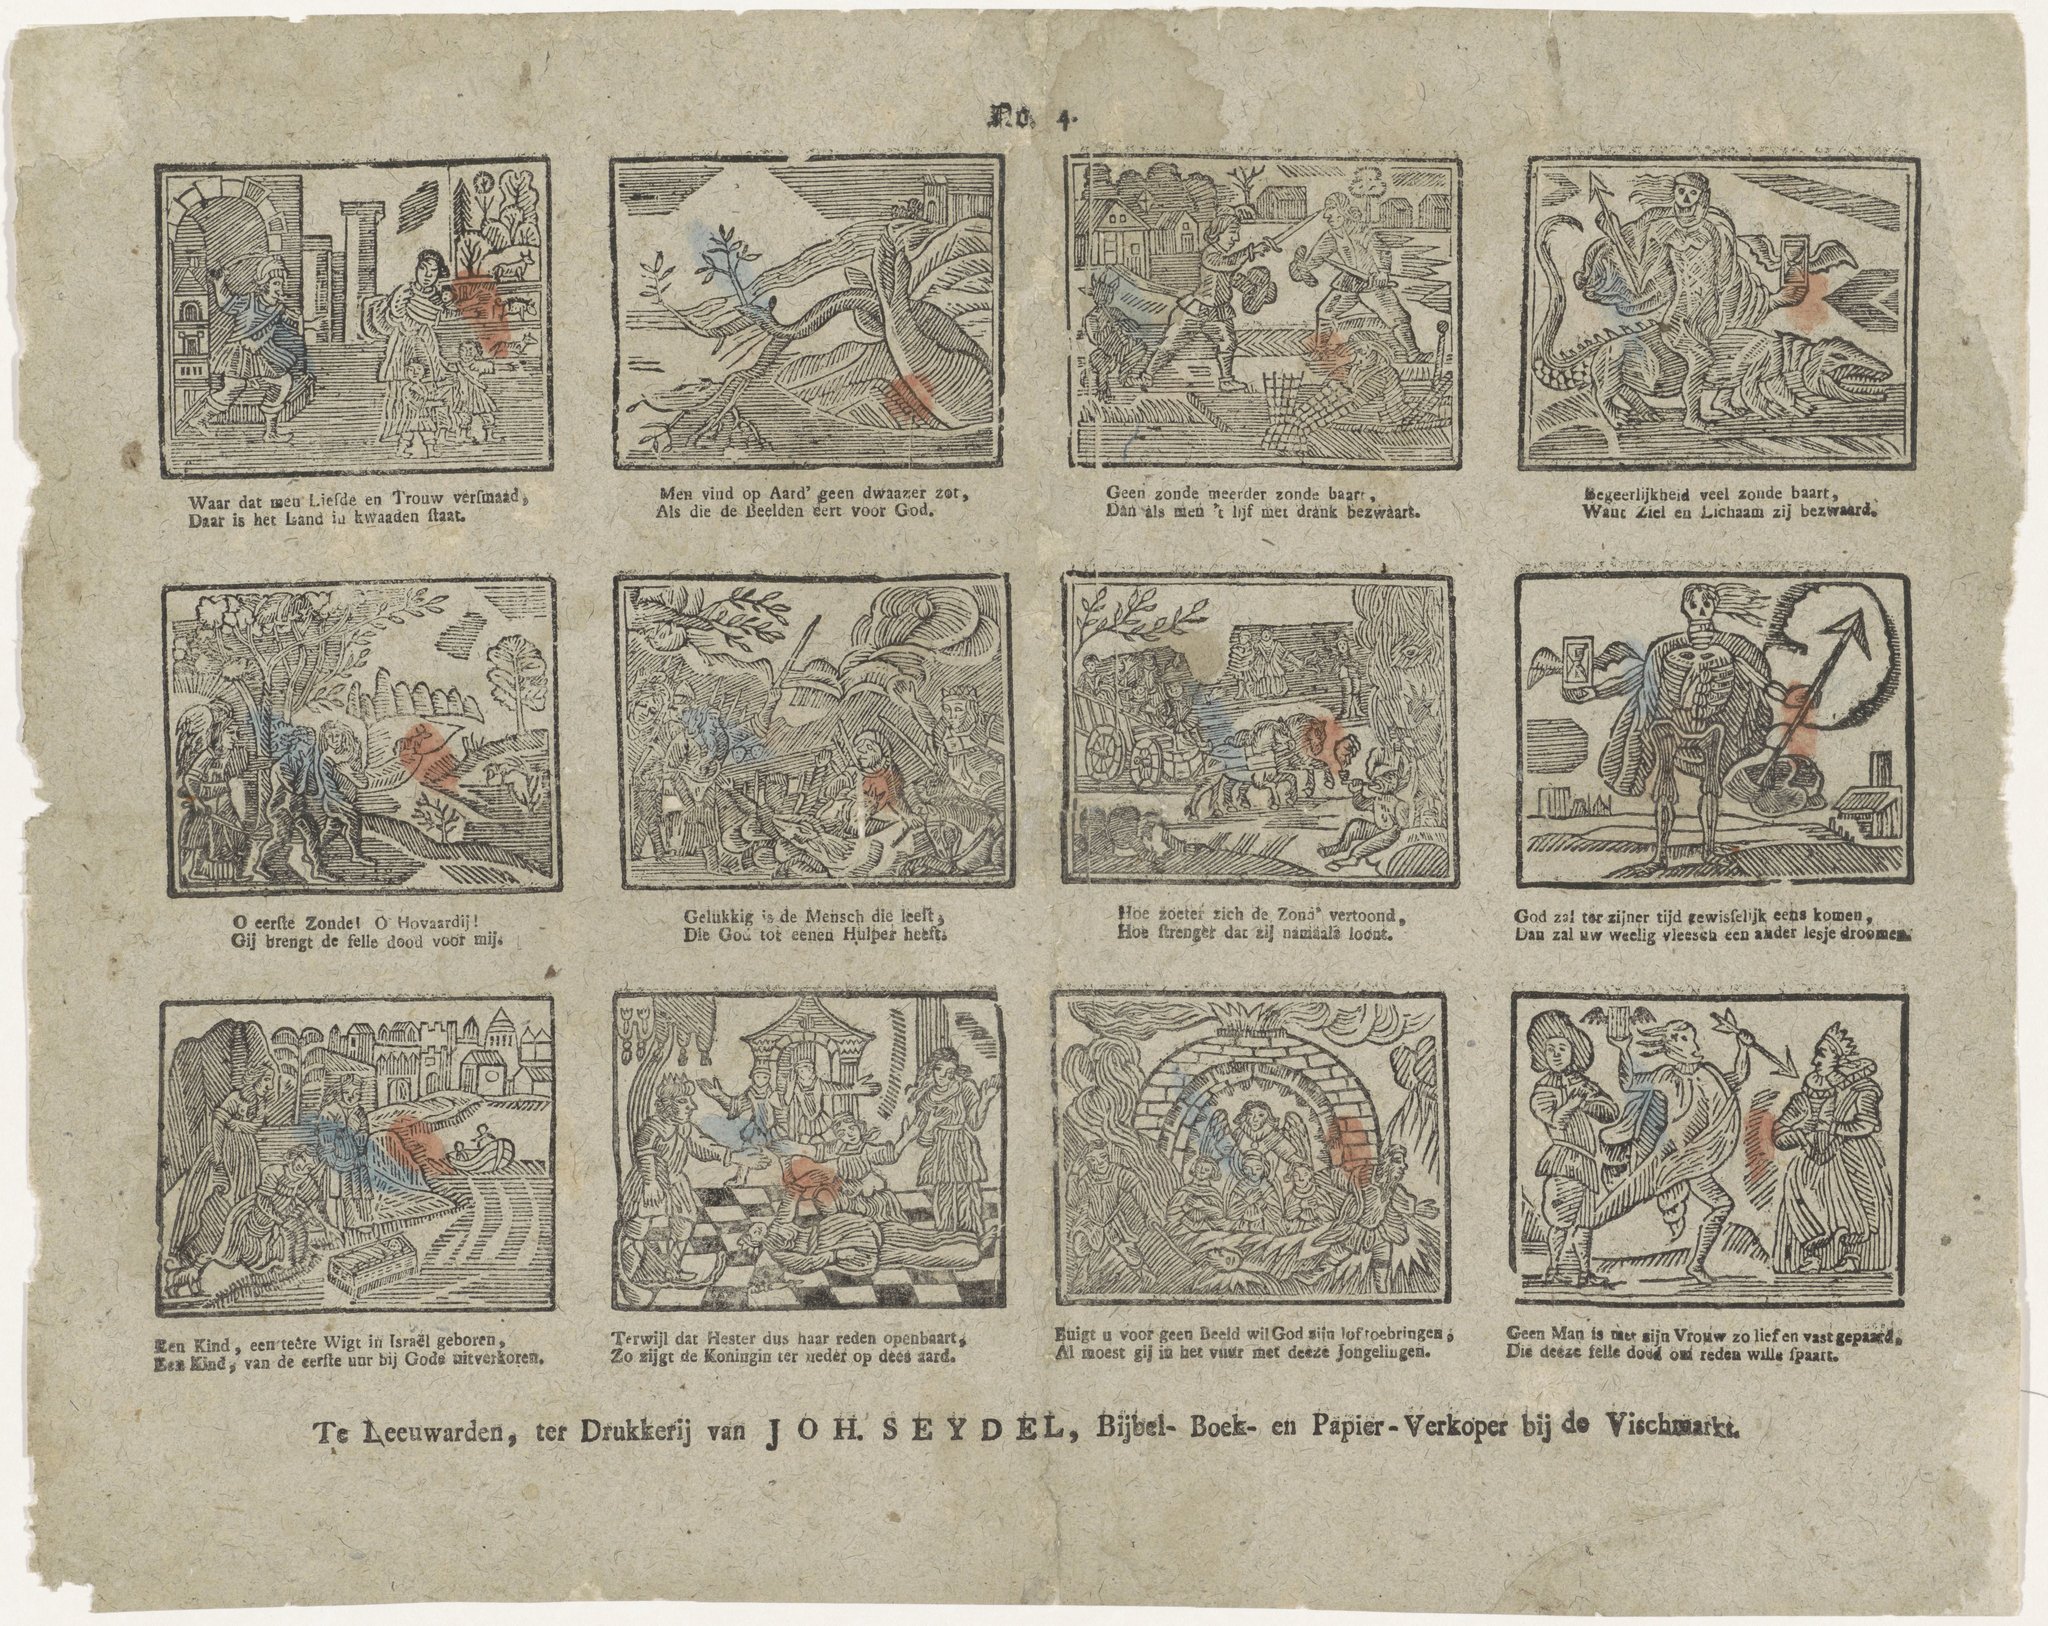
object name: popular print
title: Bijbelse en moralistische taferelen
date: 1776-1813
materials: paper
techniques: colour, letterpress printing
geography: netherlands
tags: morality, old testament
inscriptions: collector's mark: Lugt 2760, collector's mark: Lugt 2228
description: Blad met 12 Bijbelse en moralistische taferelen. Onder elke afbeelding een tweeregelig vers. Genummerd midden boven: No. 4.